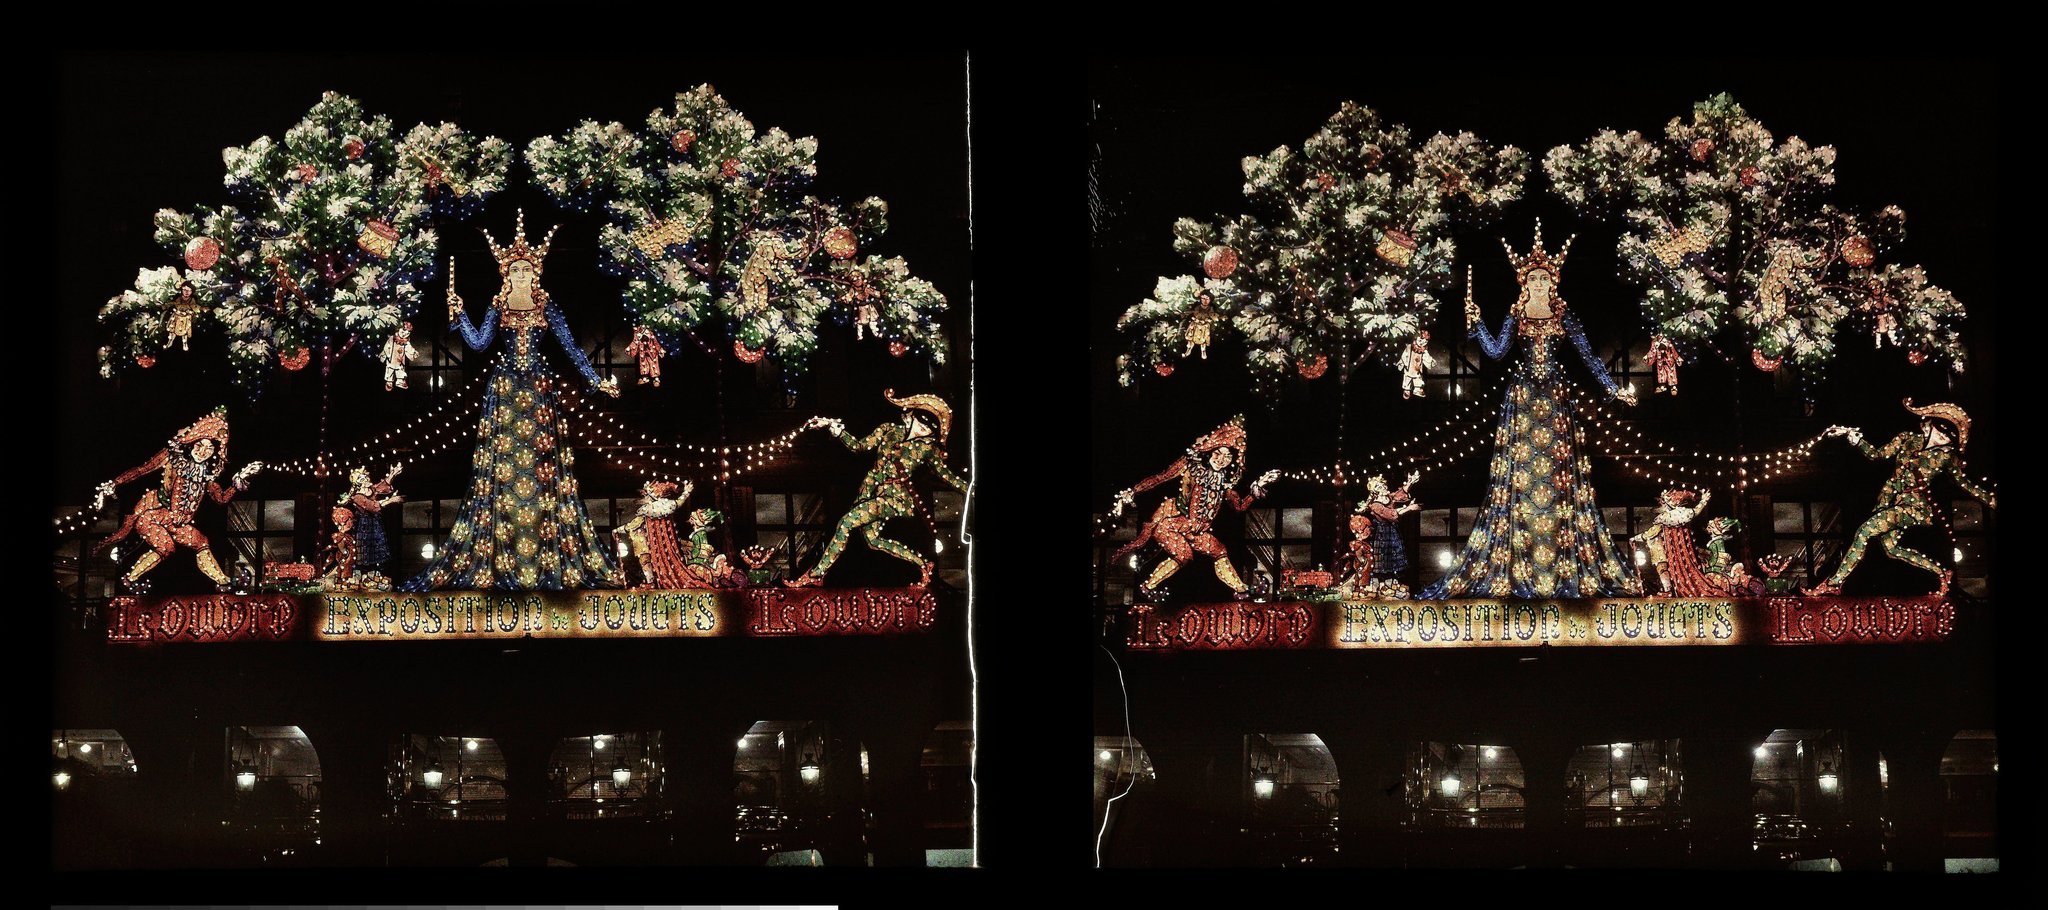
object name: stereograph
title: Lichtreclame op de gevel van het warenhuis Les Grands Magasins du Louvre, Parijs, vermoedelijk ontworpen door Fernand Jacopozzi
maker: léon gimpel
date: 1912-1922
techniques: autochrome process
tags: paris